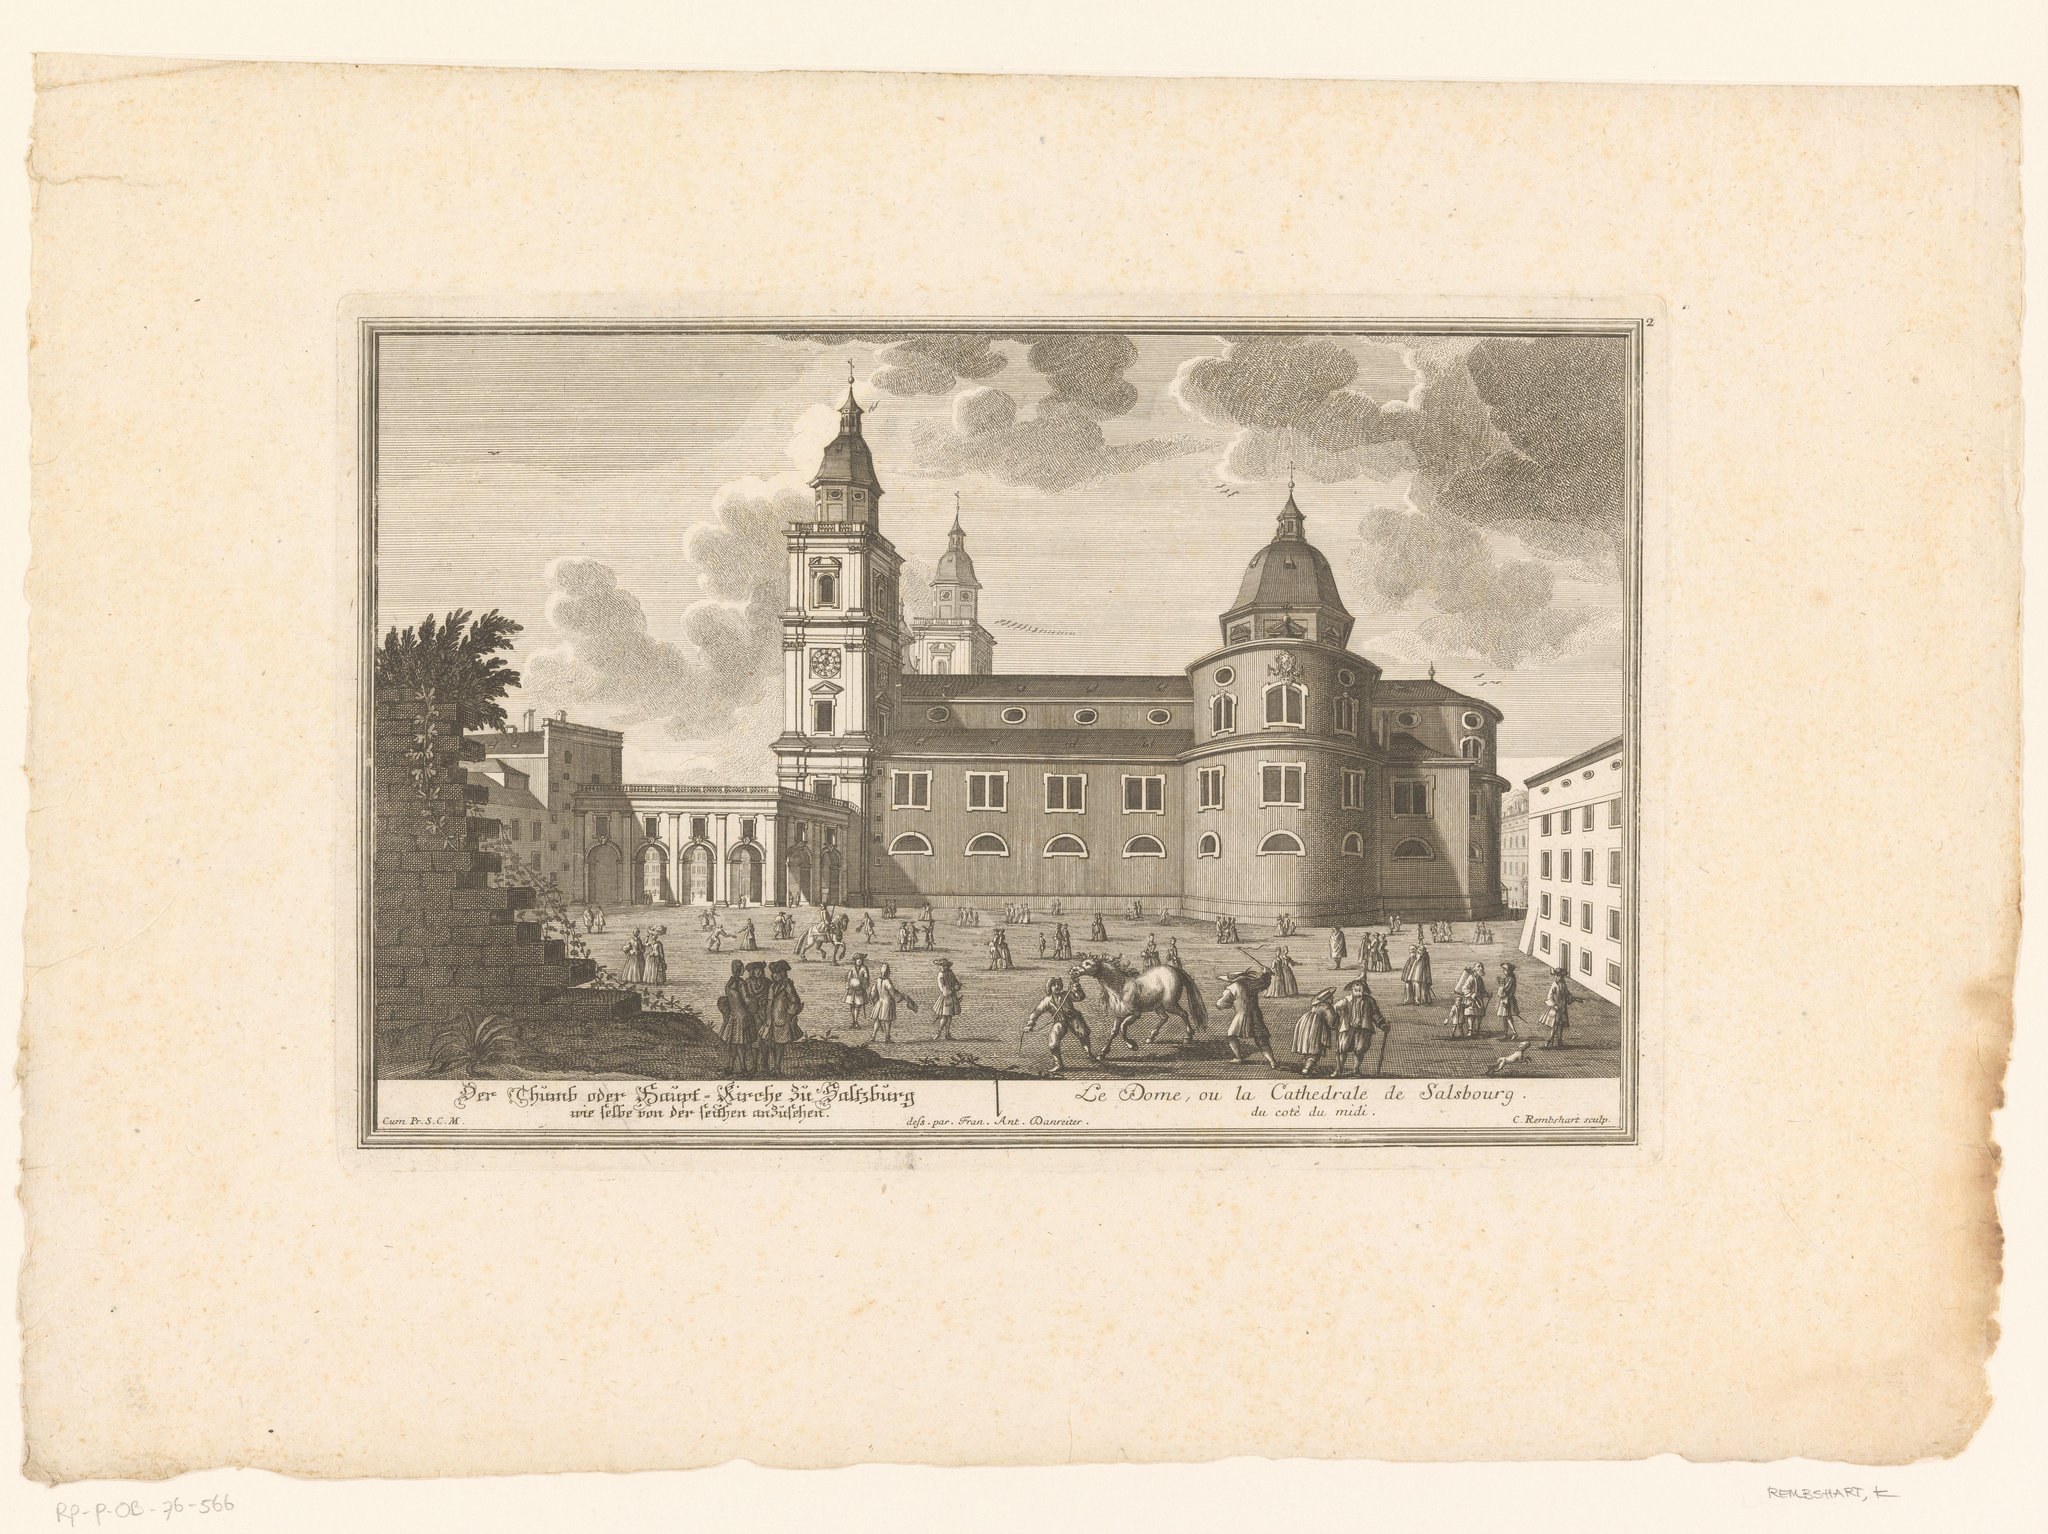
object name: print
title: Der Thumb oder Haupt-Kirche zu Saltzburg (...) / Le Dome, ou la Cathedrale de Salsbourg (...)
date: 1730-1740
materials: paper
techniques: engraving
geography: augsburg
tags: parts of church exterior and annexes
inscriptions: collector's mark: Lugt 2228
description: Zuidzijde van de dom van Salzburg en de Kapitelplatz.